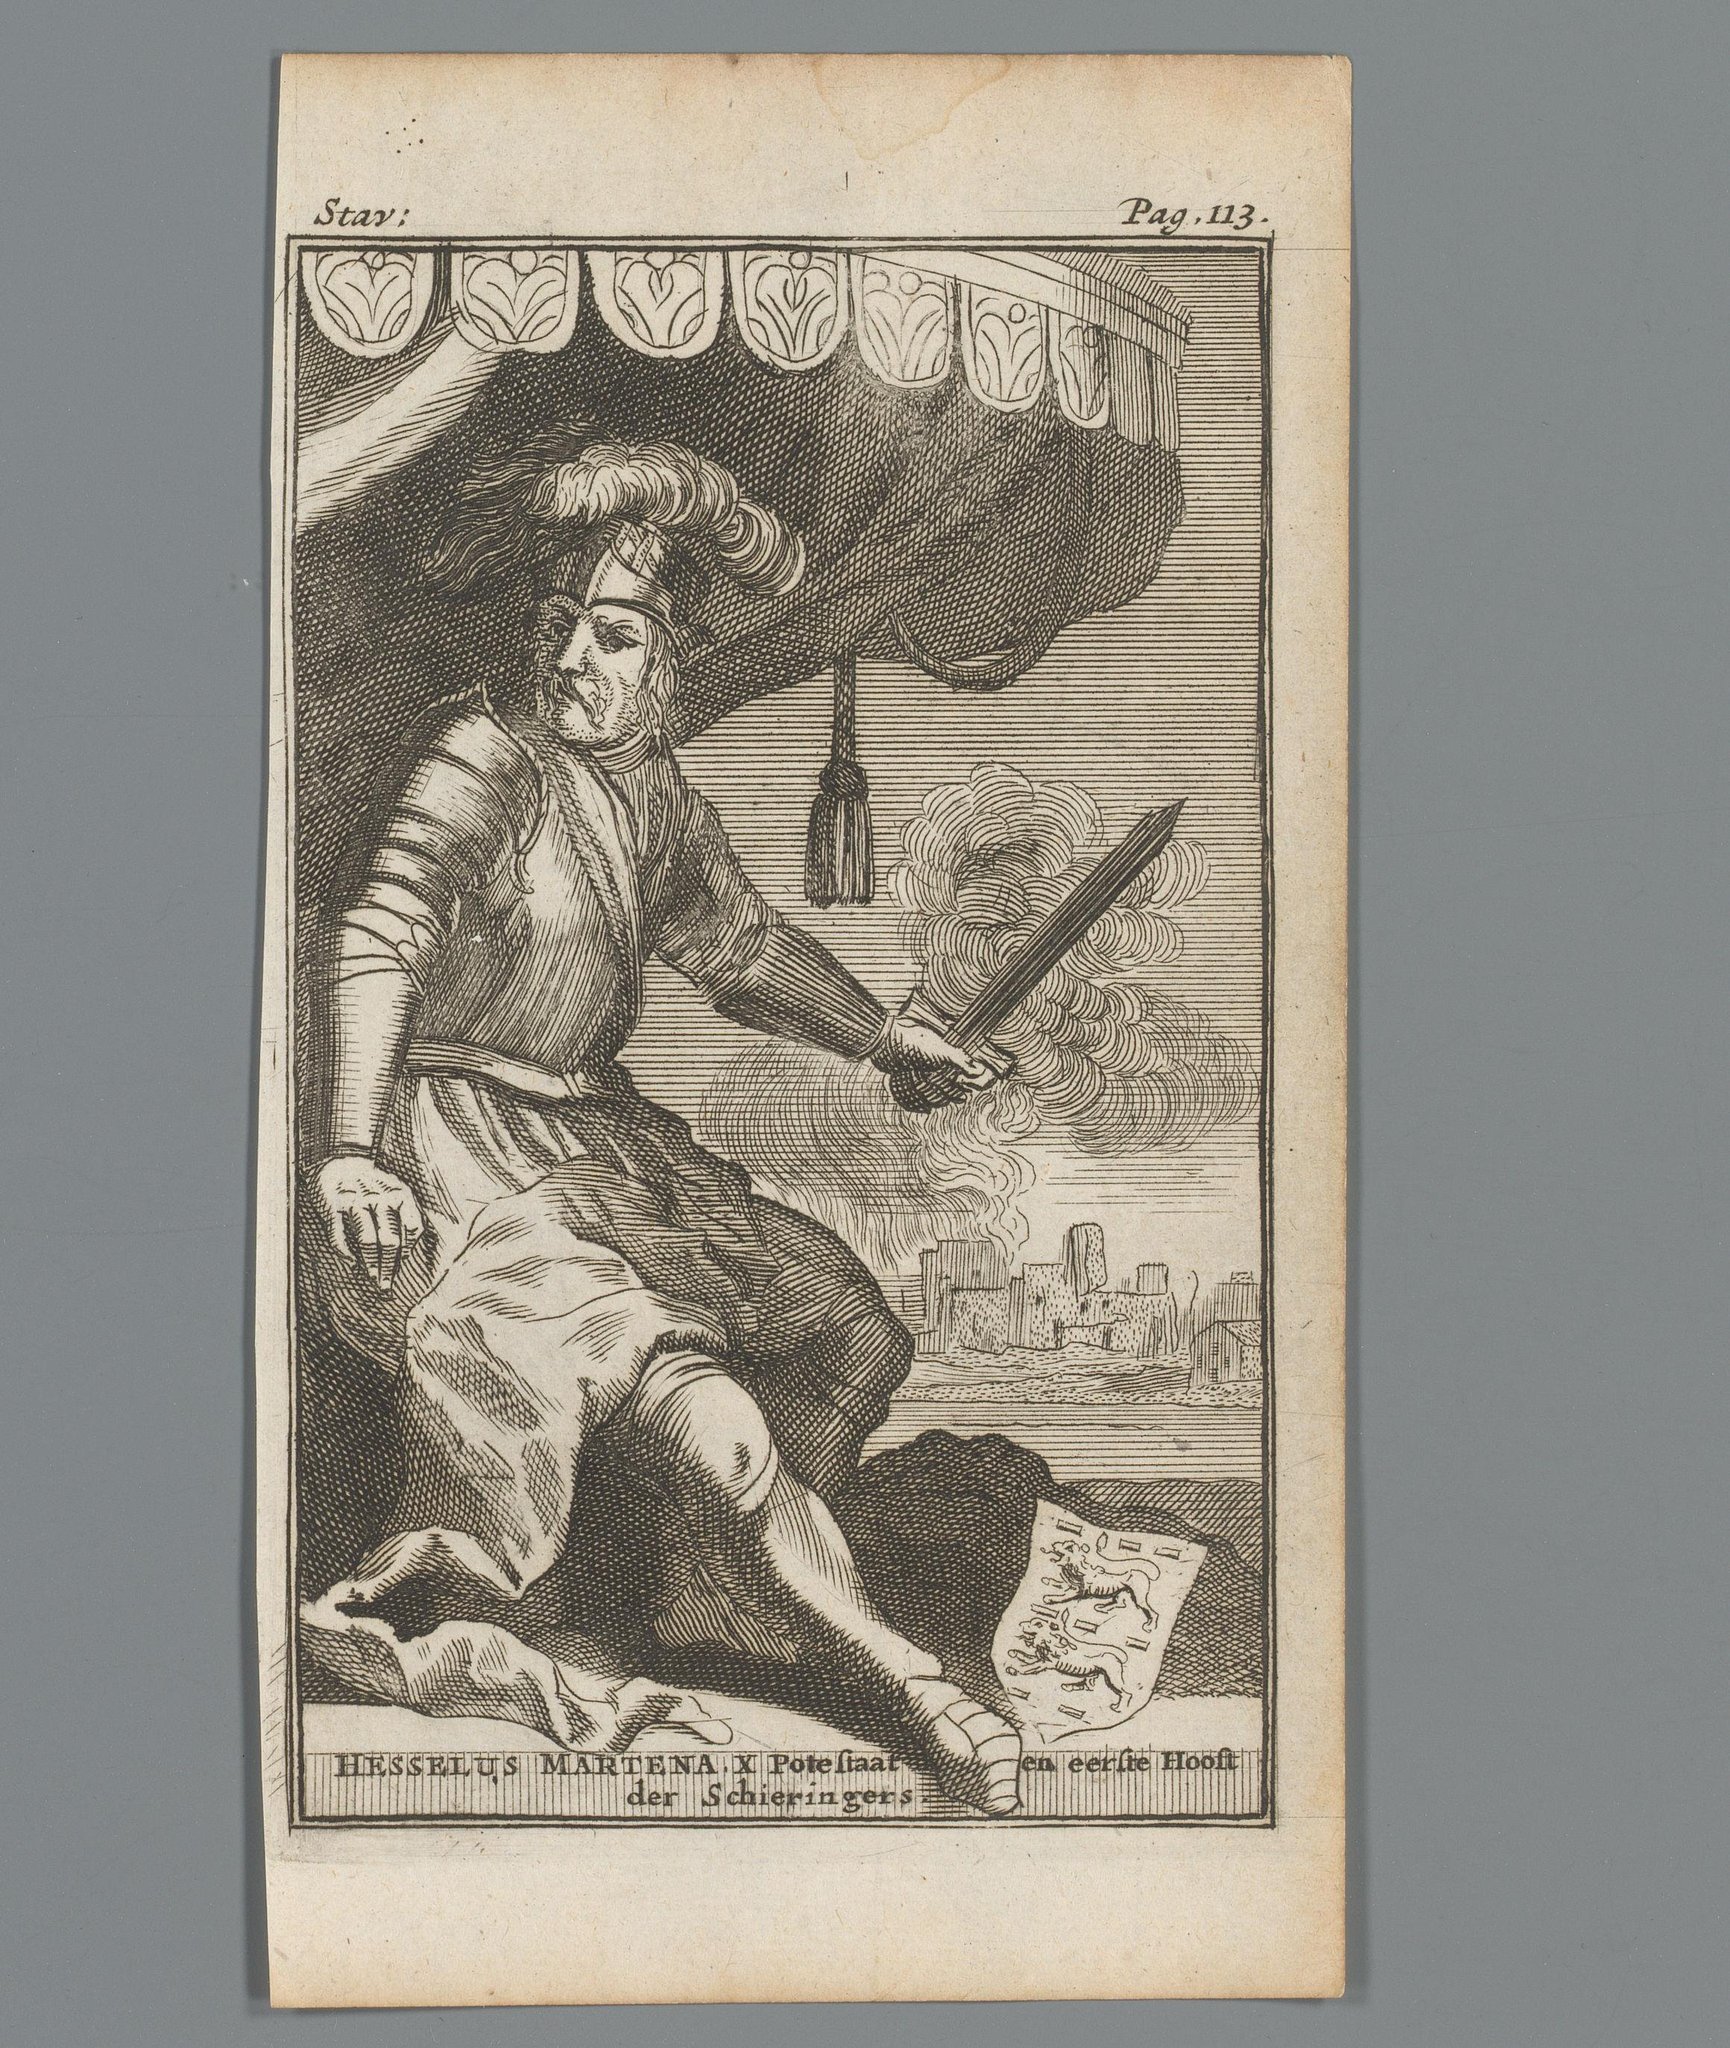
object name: book illustration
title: Portret van Hessel Martena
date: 1702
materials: paper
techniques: etching, letterpress printing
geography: amsterdam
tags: historical persons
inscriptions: inscription: ‘Hesselus Martena/X (...) pylen mede deelen.’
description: Prent uit: Soeteboom, Hendrik Jacobsz. Oud-heden van Zaan-land, Stavoren, Vronen en Waterland ... Alles uit de oudheden nagespeurd, en met autentique stukken bewaarheid. Amsterdam: Wilhem Linnig van Koppenol, 1702, dl. 2.